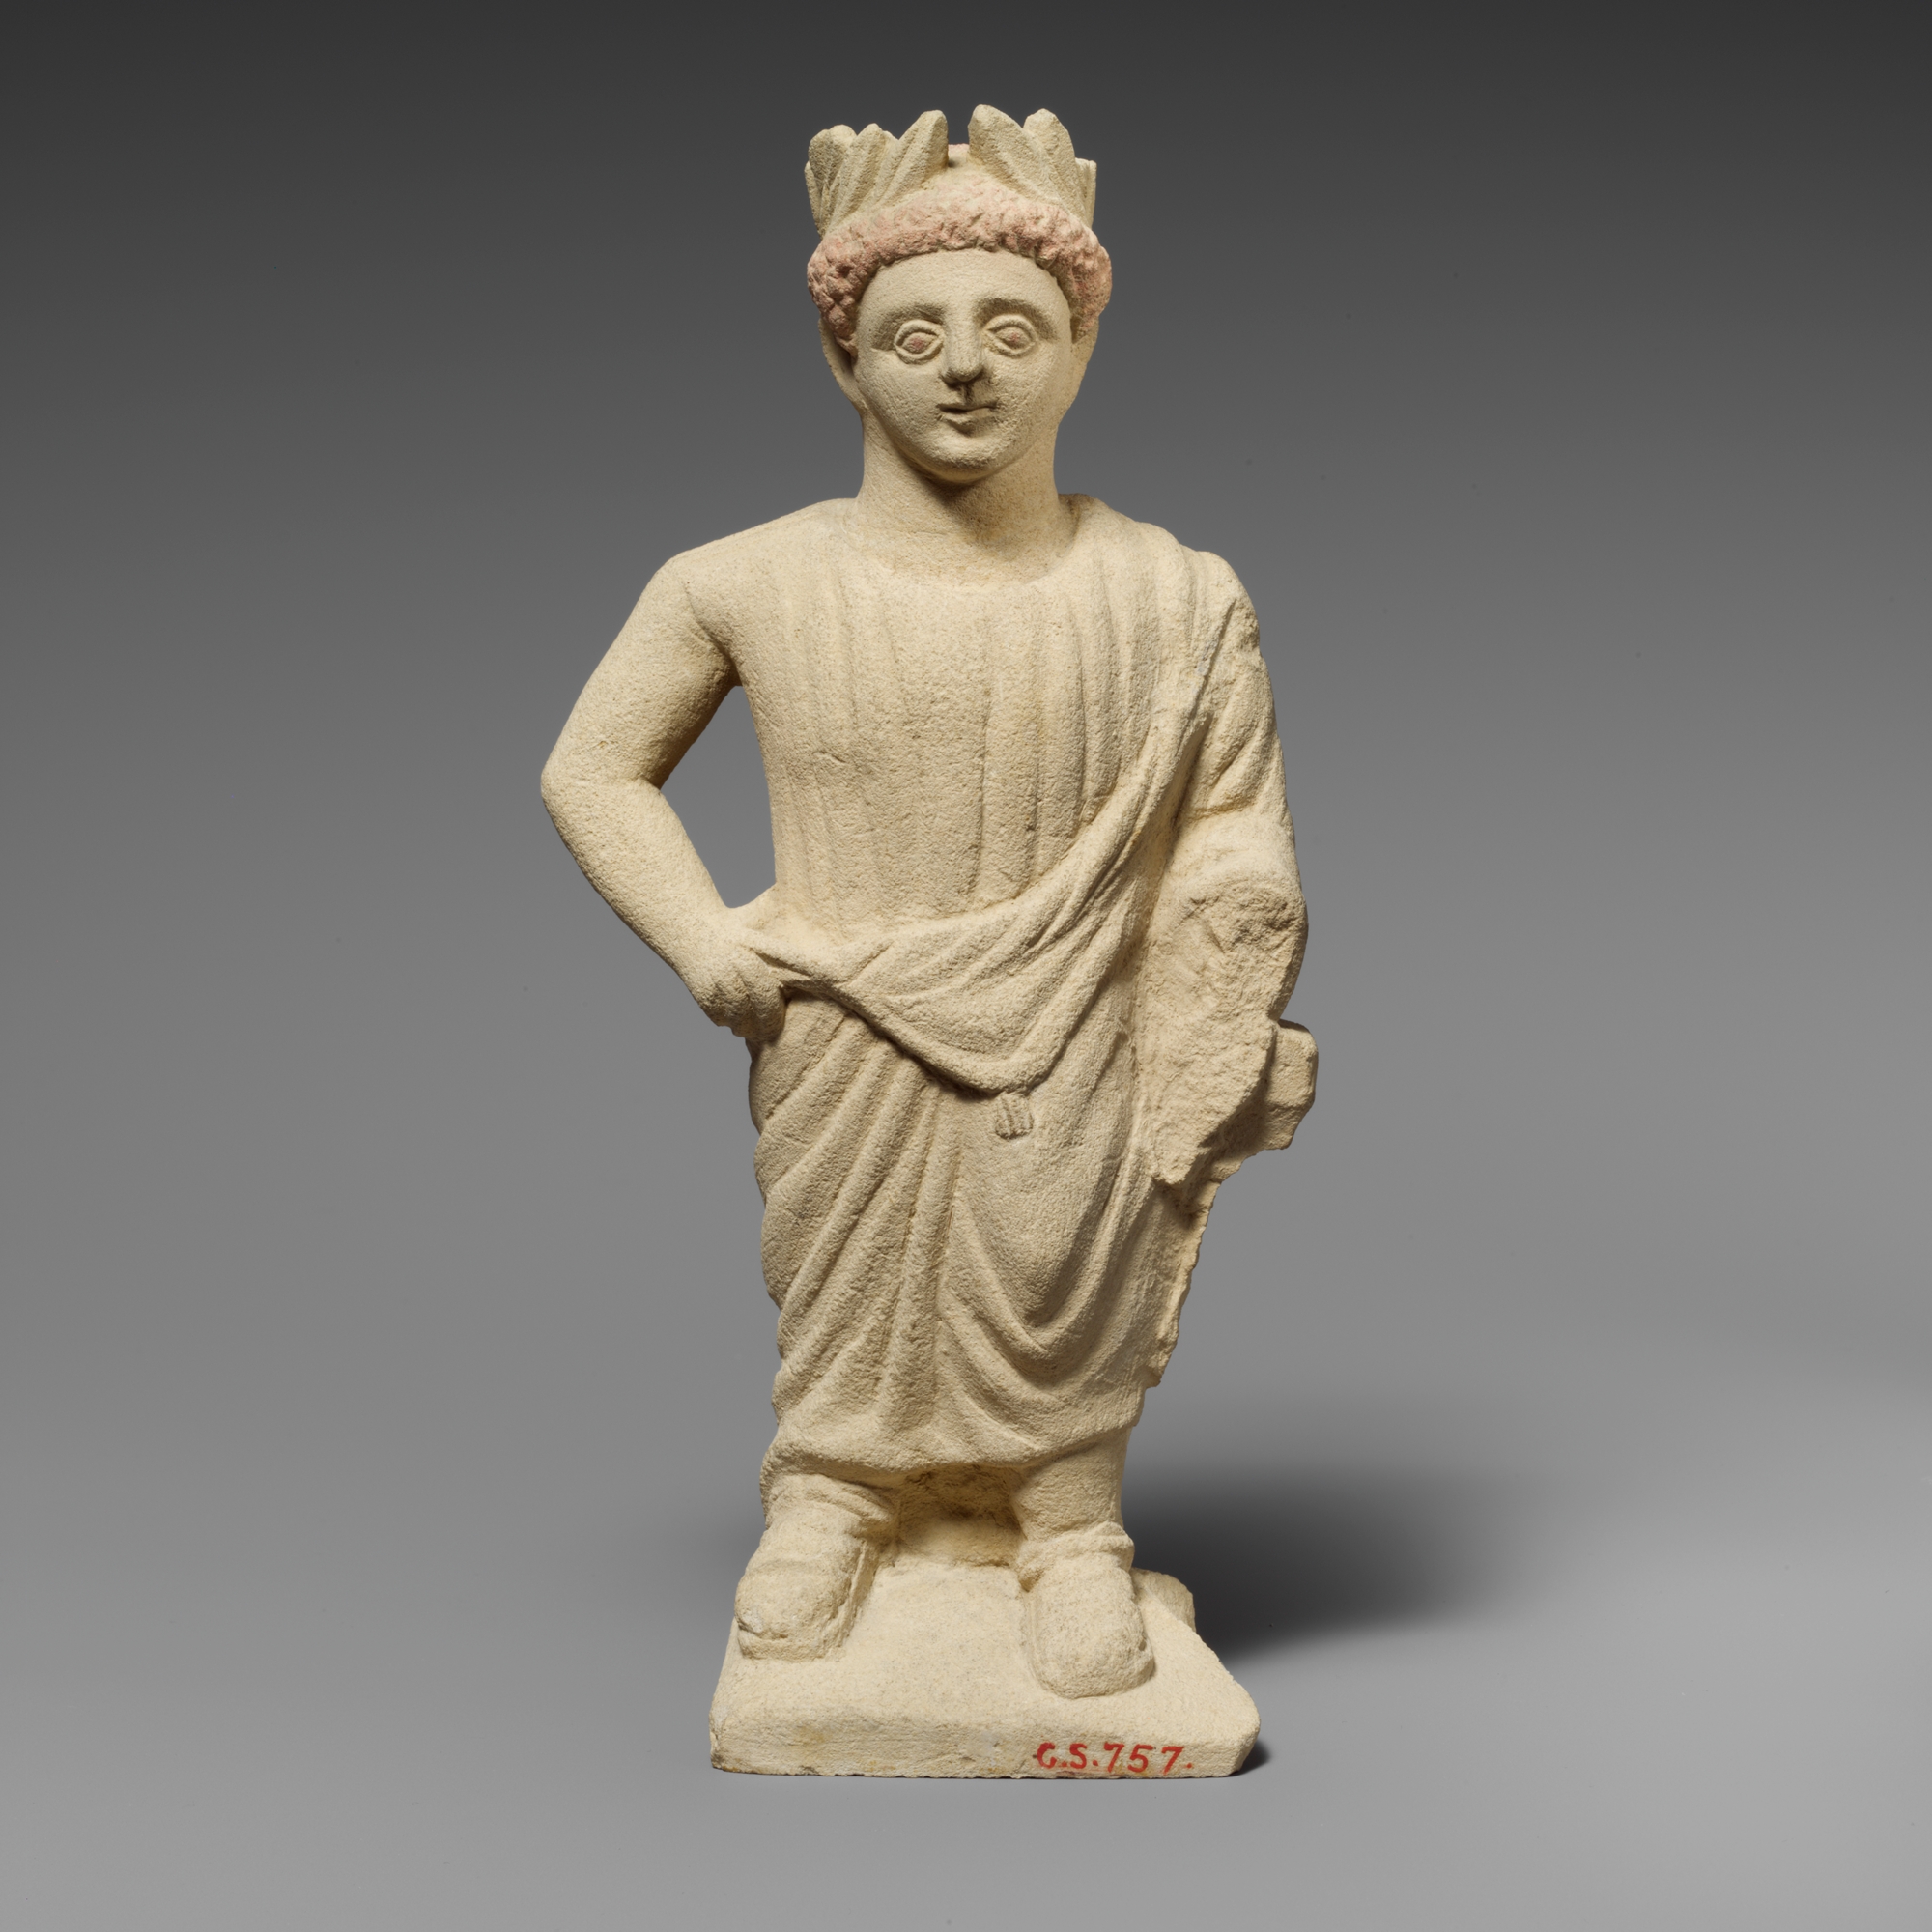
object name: statuette of a votary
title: Limestone statuette of a beardless male votary with a wreath of leaves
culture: cypriot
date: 400-301 BCE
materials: limestone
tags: men,wreaths